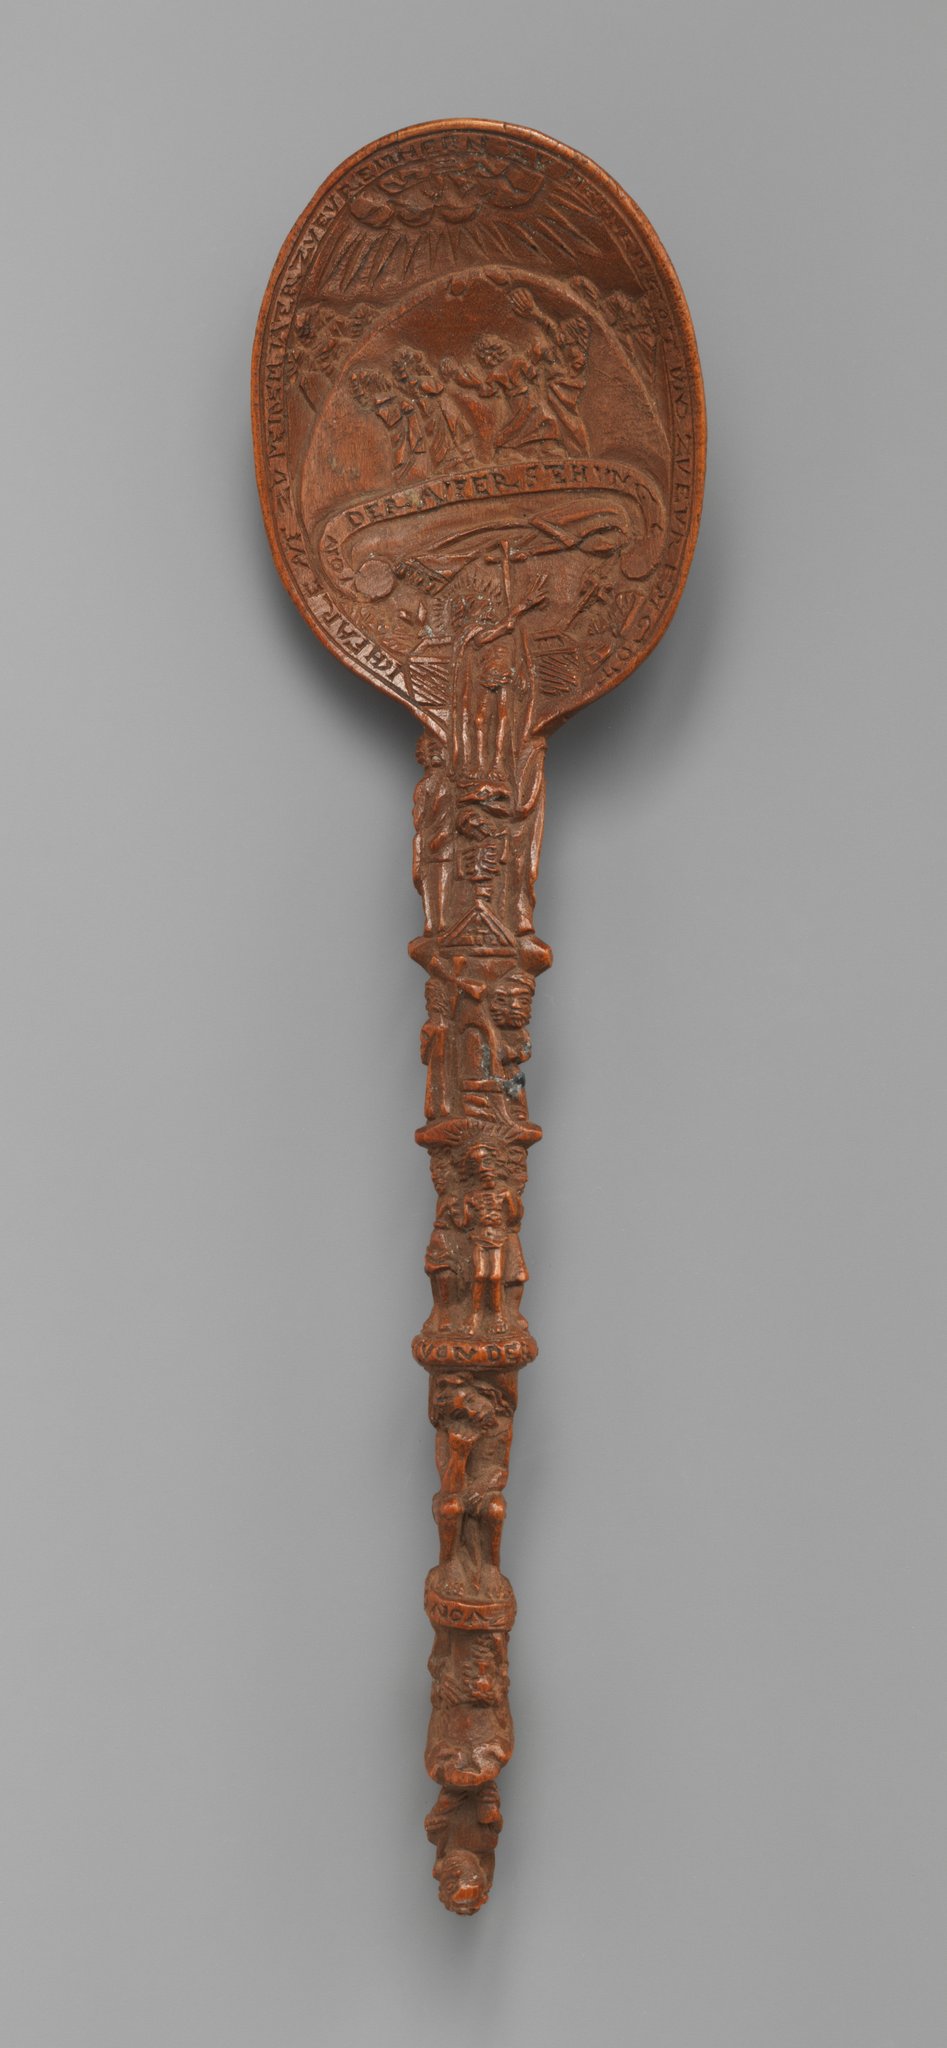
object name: spoon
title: Scenes of the Passion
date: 1651-1700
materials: wood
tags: christ